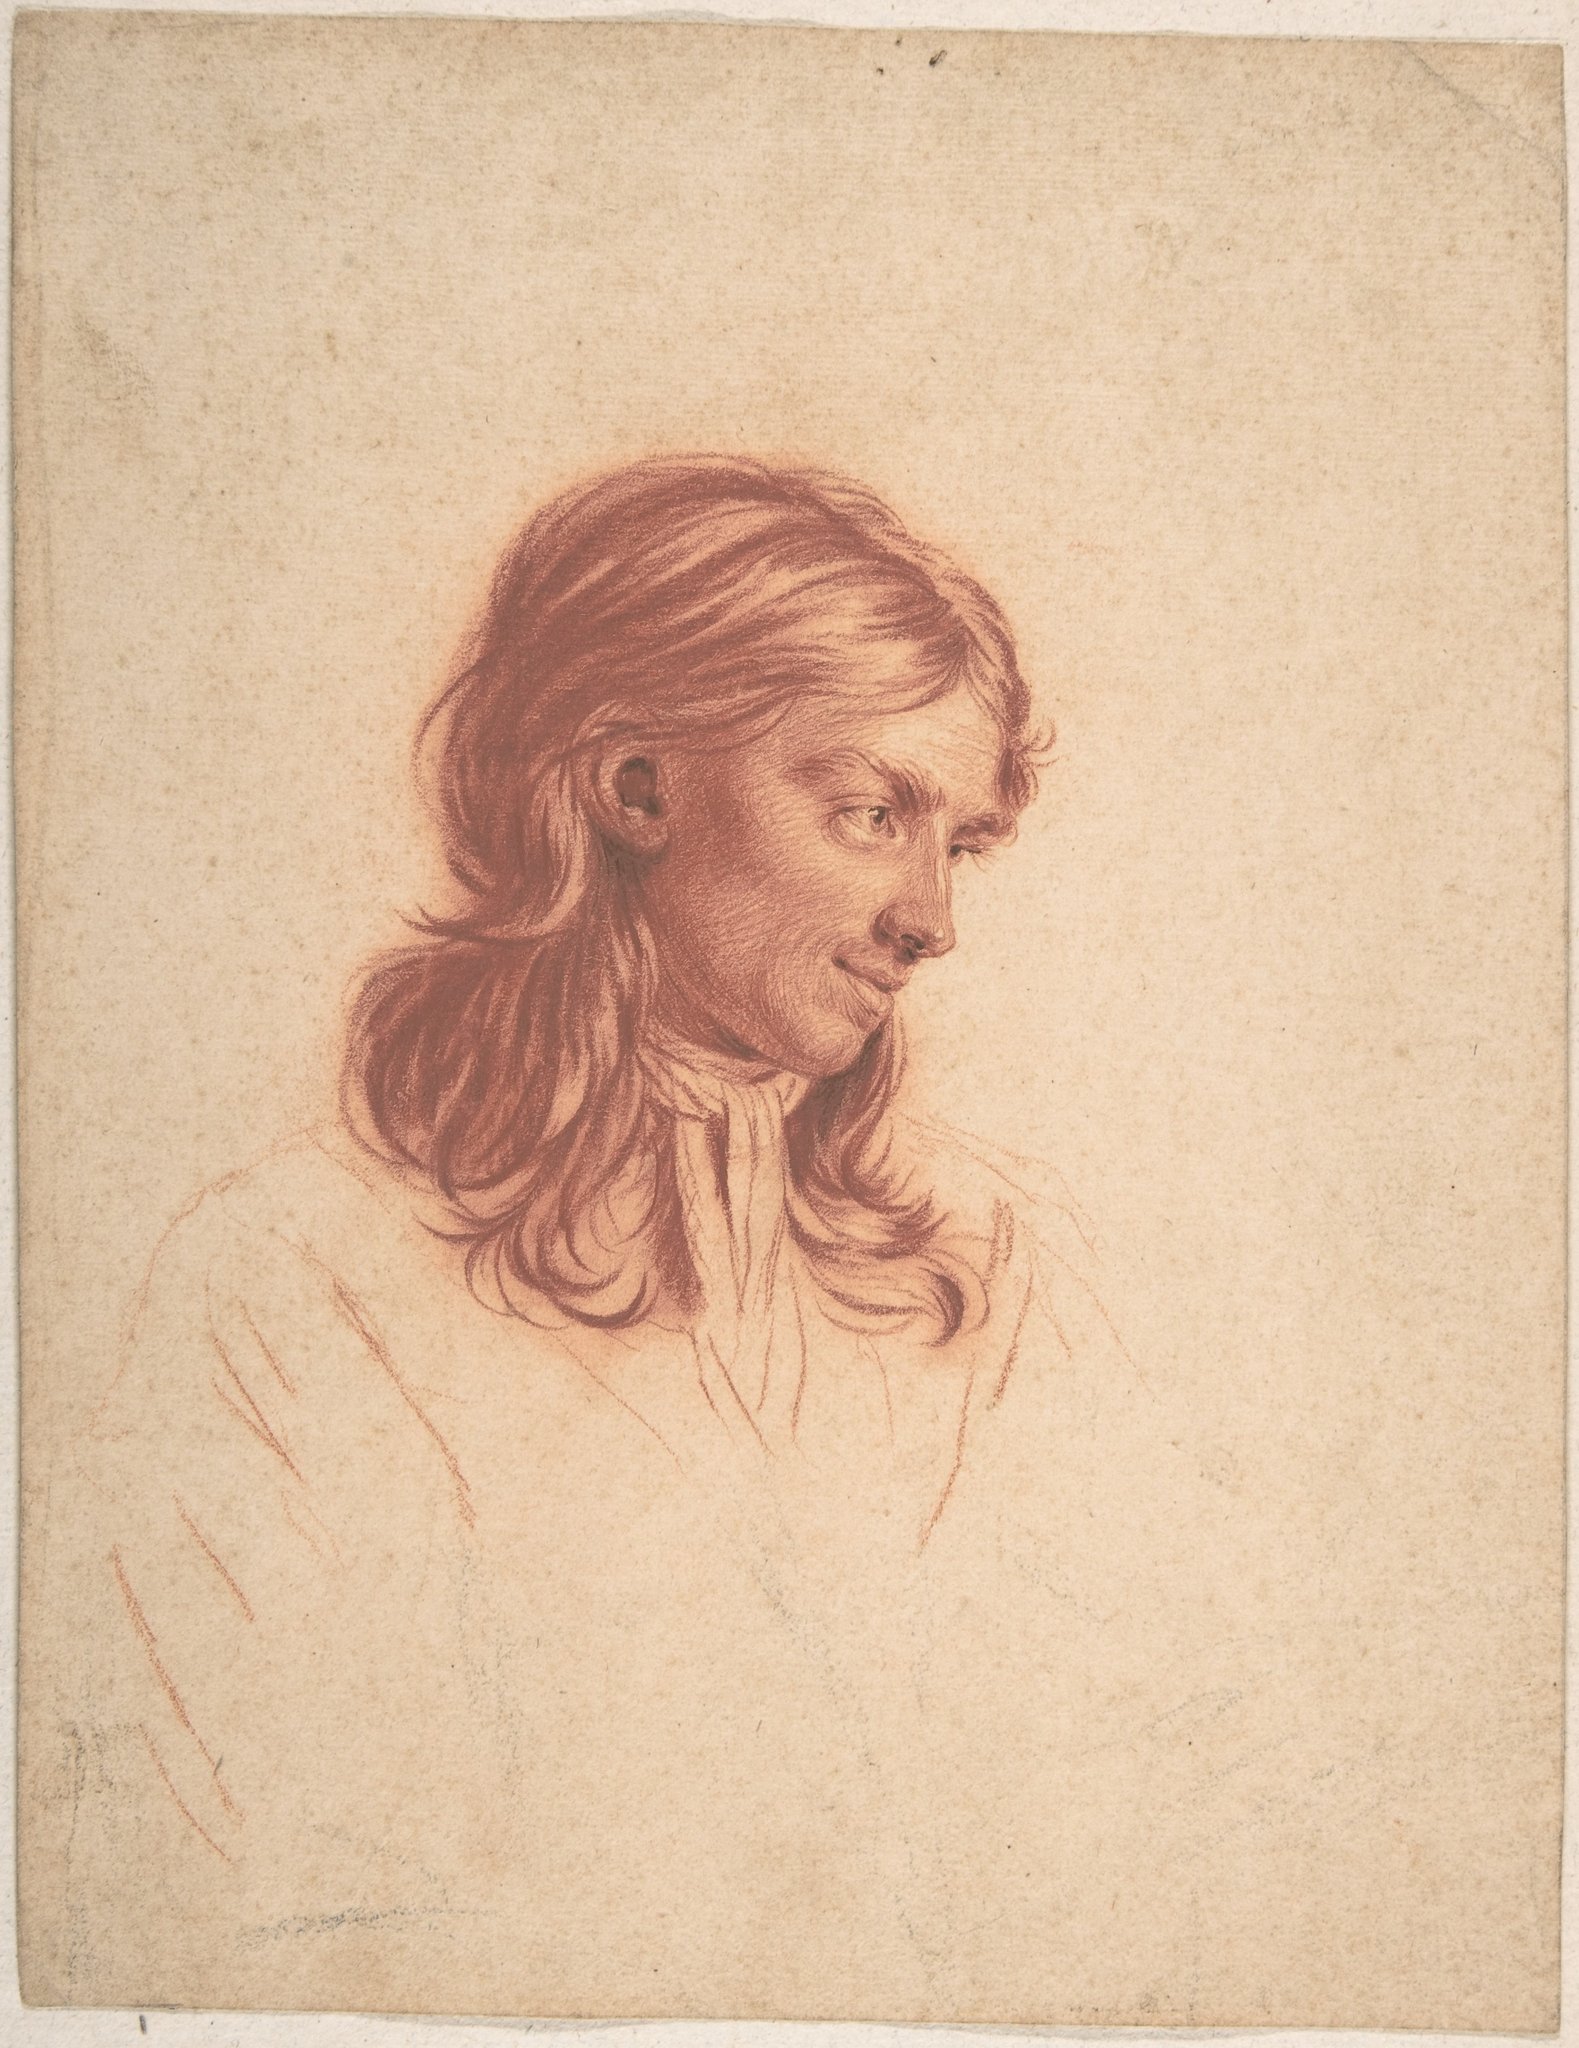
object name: drawing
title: Carter, the Colorman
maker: charles beale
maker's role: artist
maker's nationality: british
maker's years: 1660-1714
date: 1680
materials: chalk, graphite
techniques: heightening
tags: men,portraits,profiles